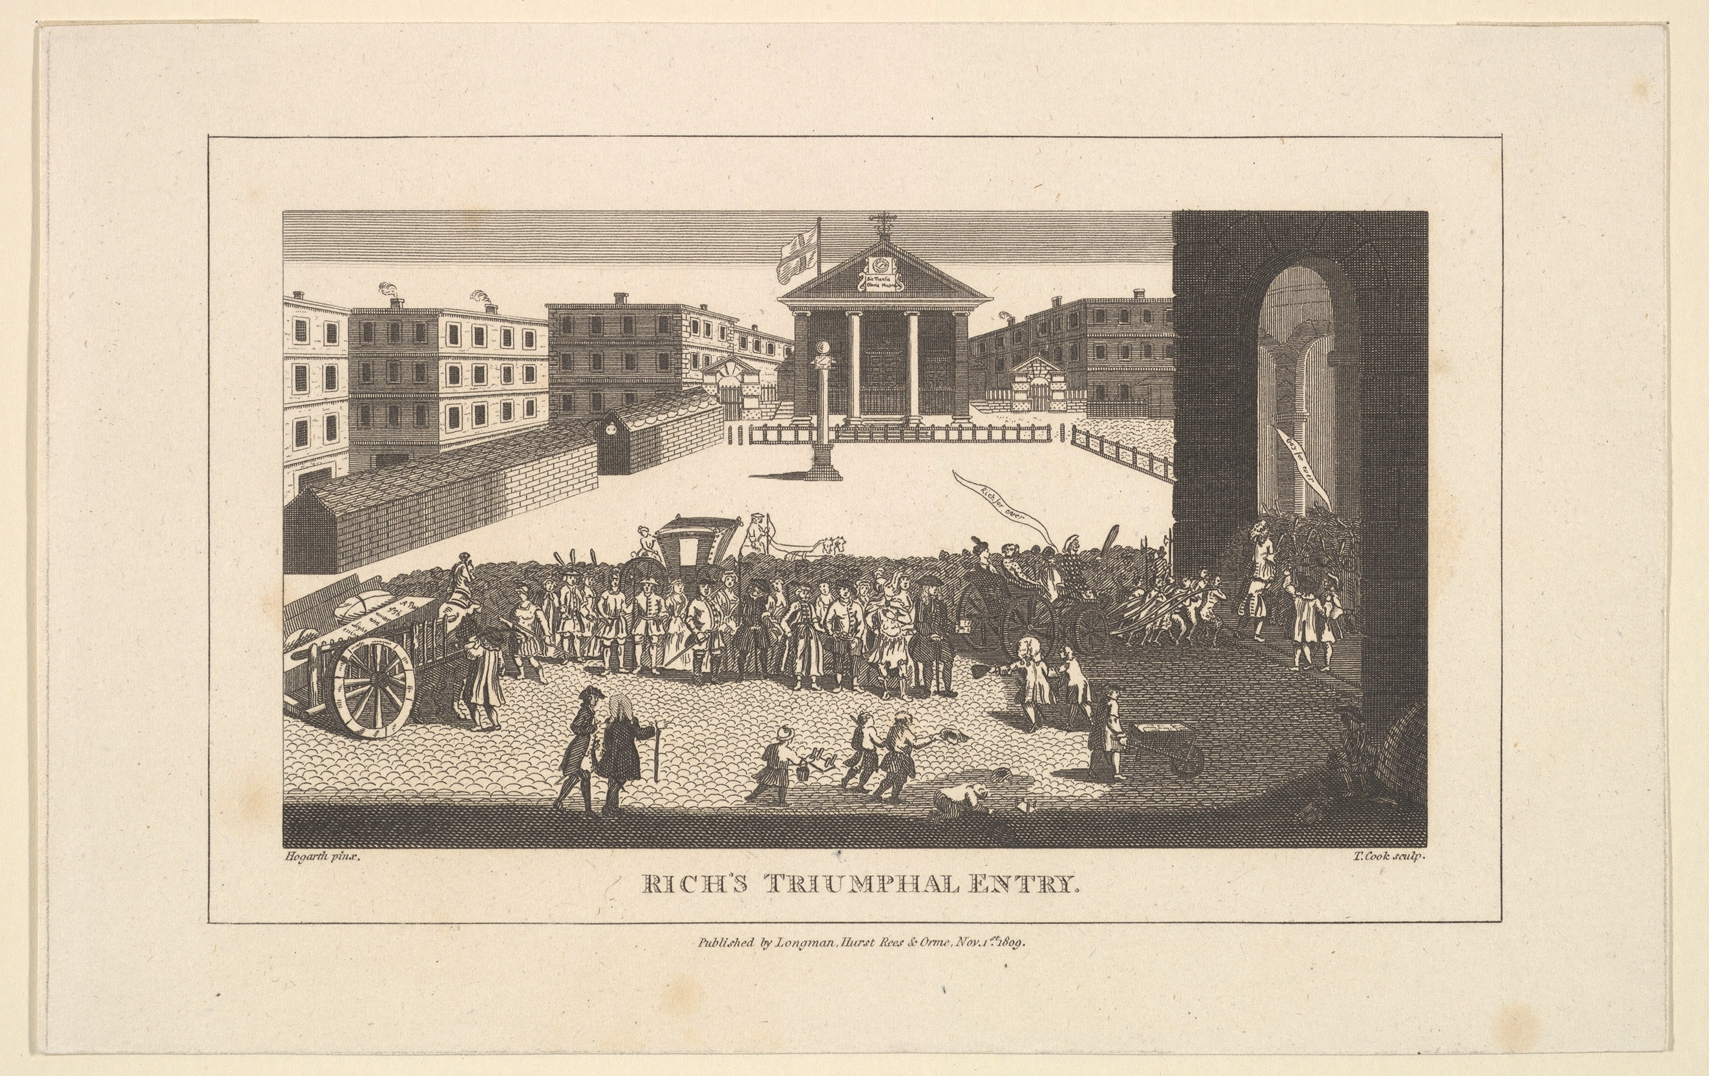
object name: print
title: Rich's Glory, or His Triumphant Entry into Covent Garden, December 1732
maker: thomas cook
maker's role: engraver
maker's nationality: british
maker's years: 1744-1818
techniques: engraving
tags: architecture,buildings,crowd,flags,carriages